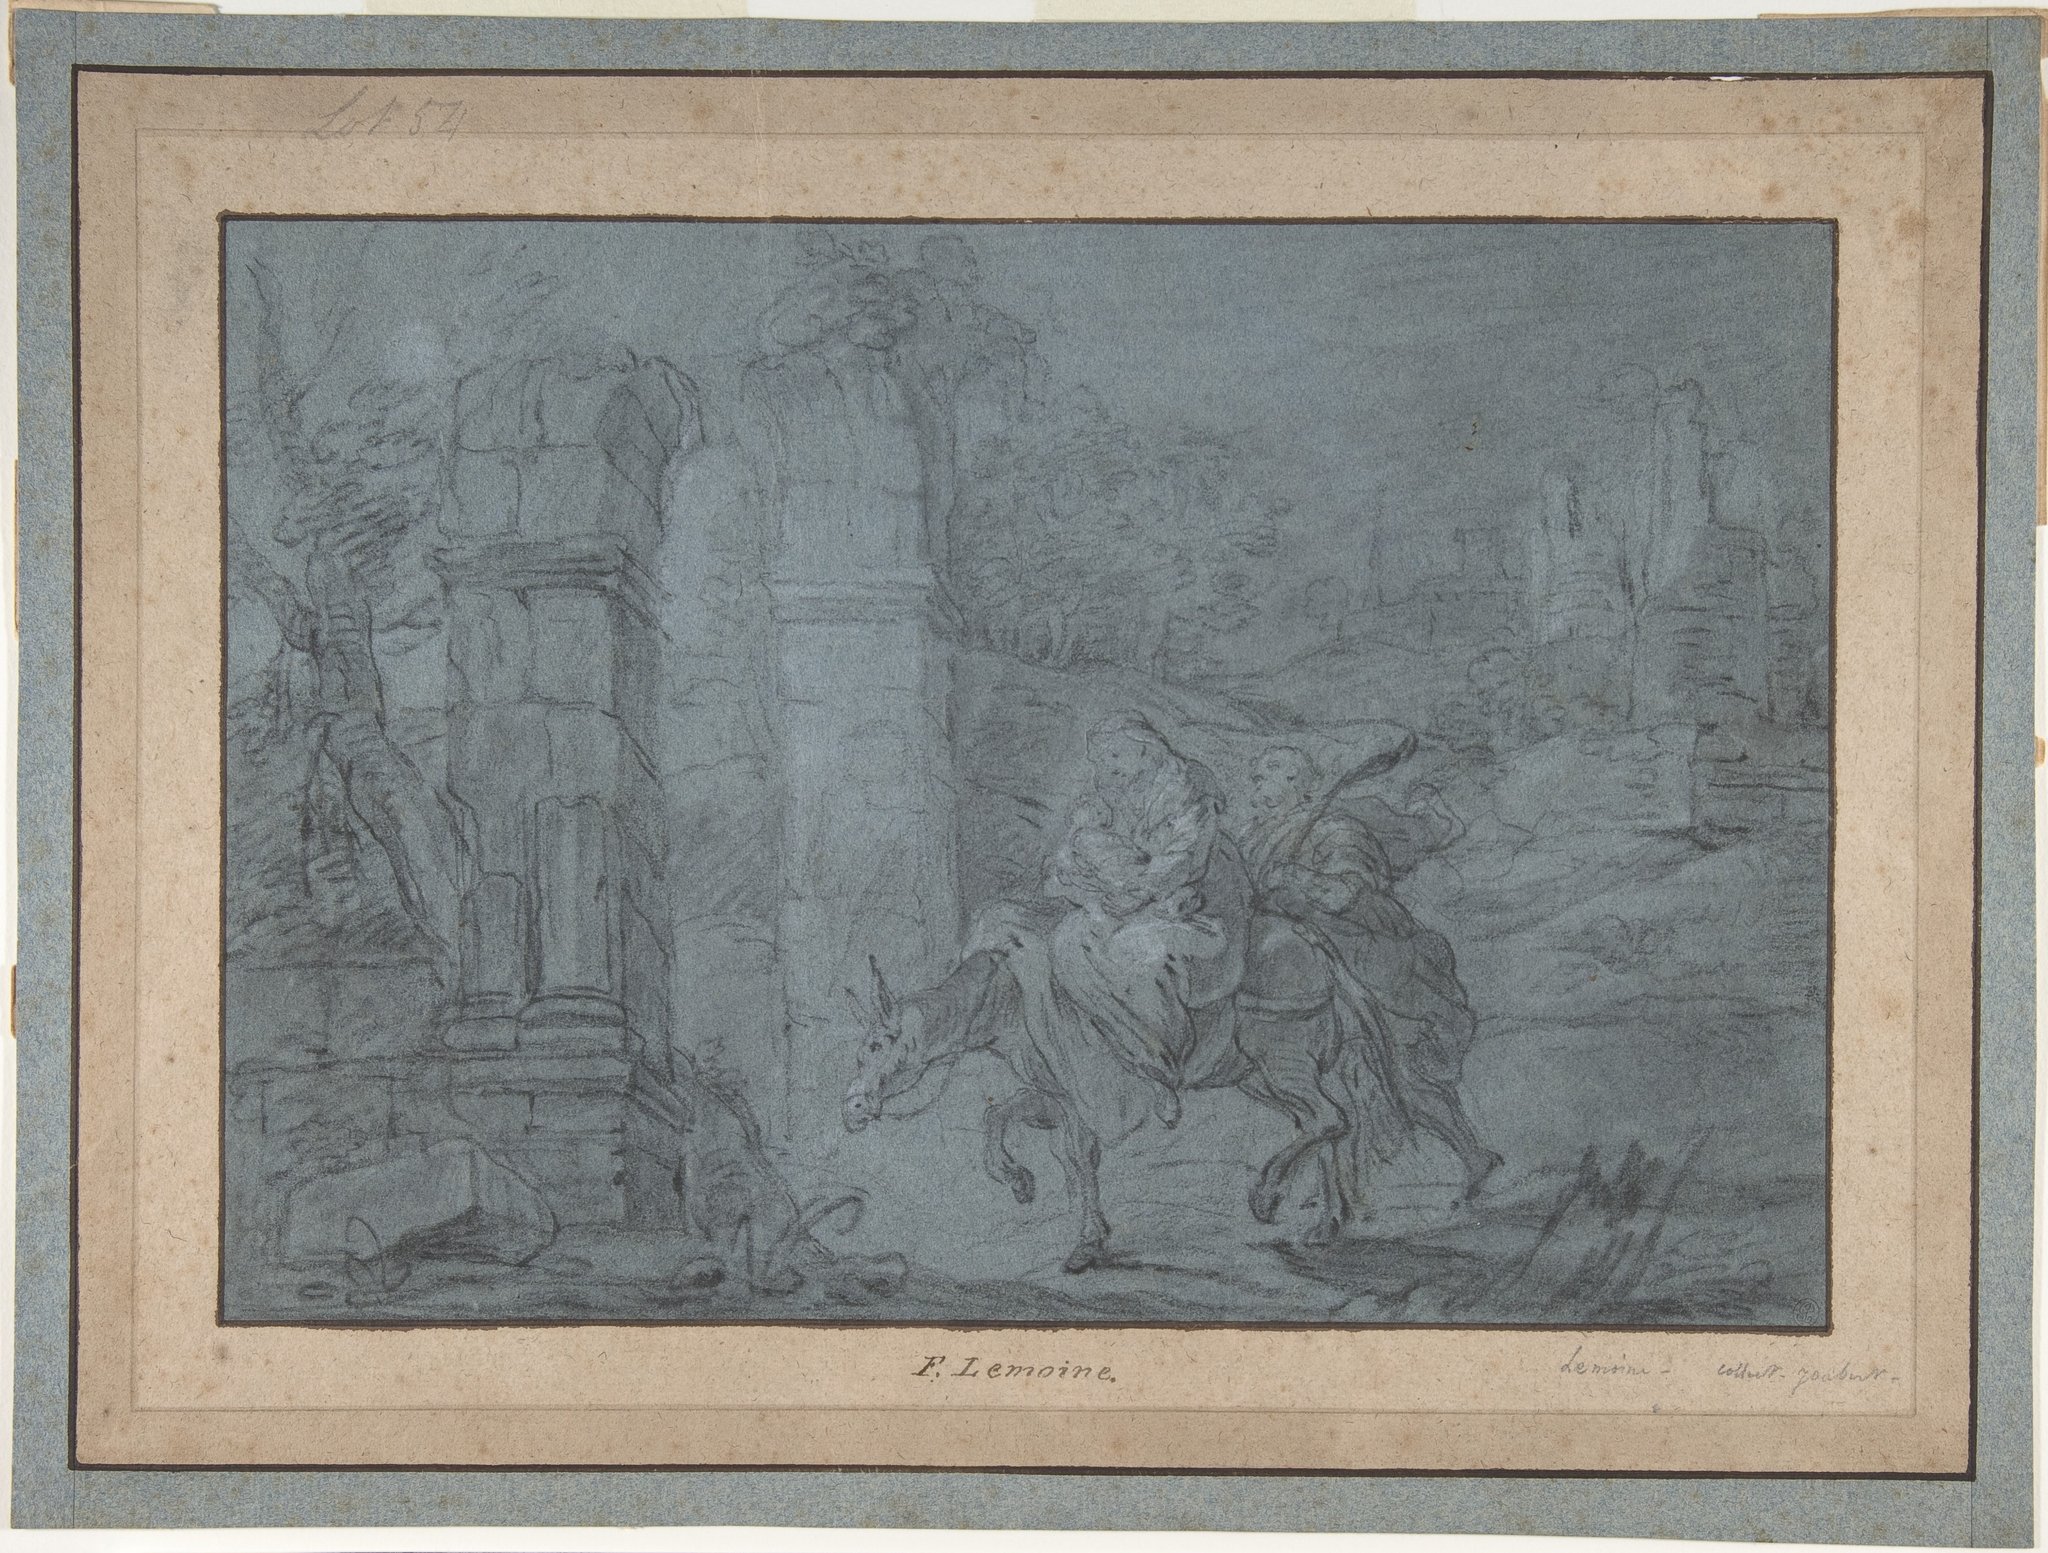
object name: drawing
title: The Flight into Egypt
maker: françois le moyne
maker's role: artist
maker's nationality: french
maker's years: 1688-1737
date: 1701-1733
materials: chalk, ink, paper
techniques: heightening, pen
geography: france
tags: men,horses